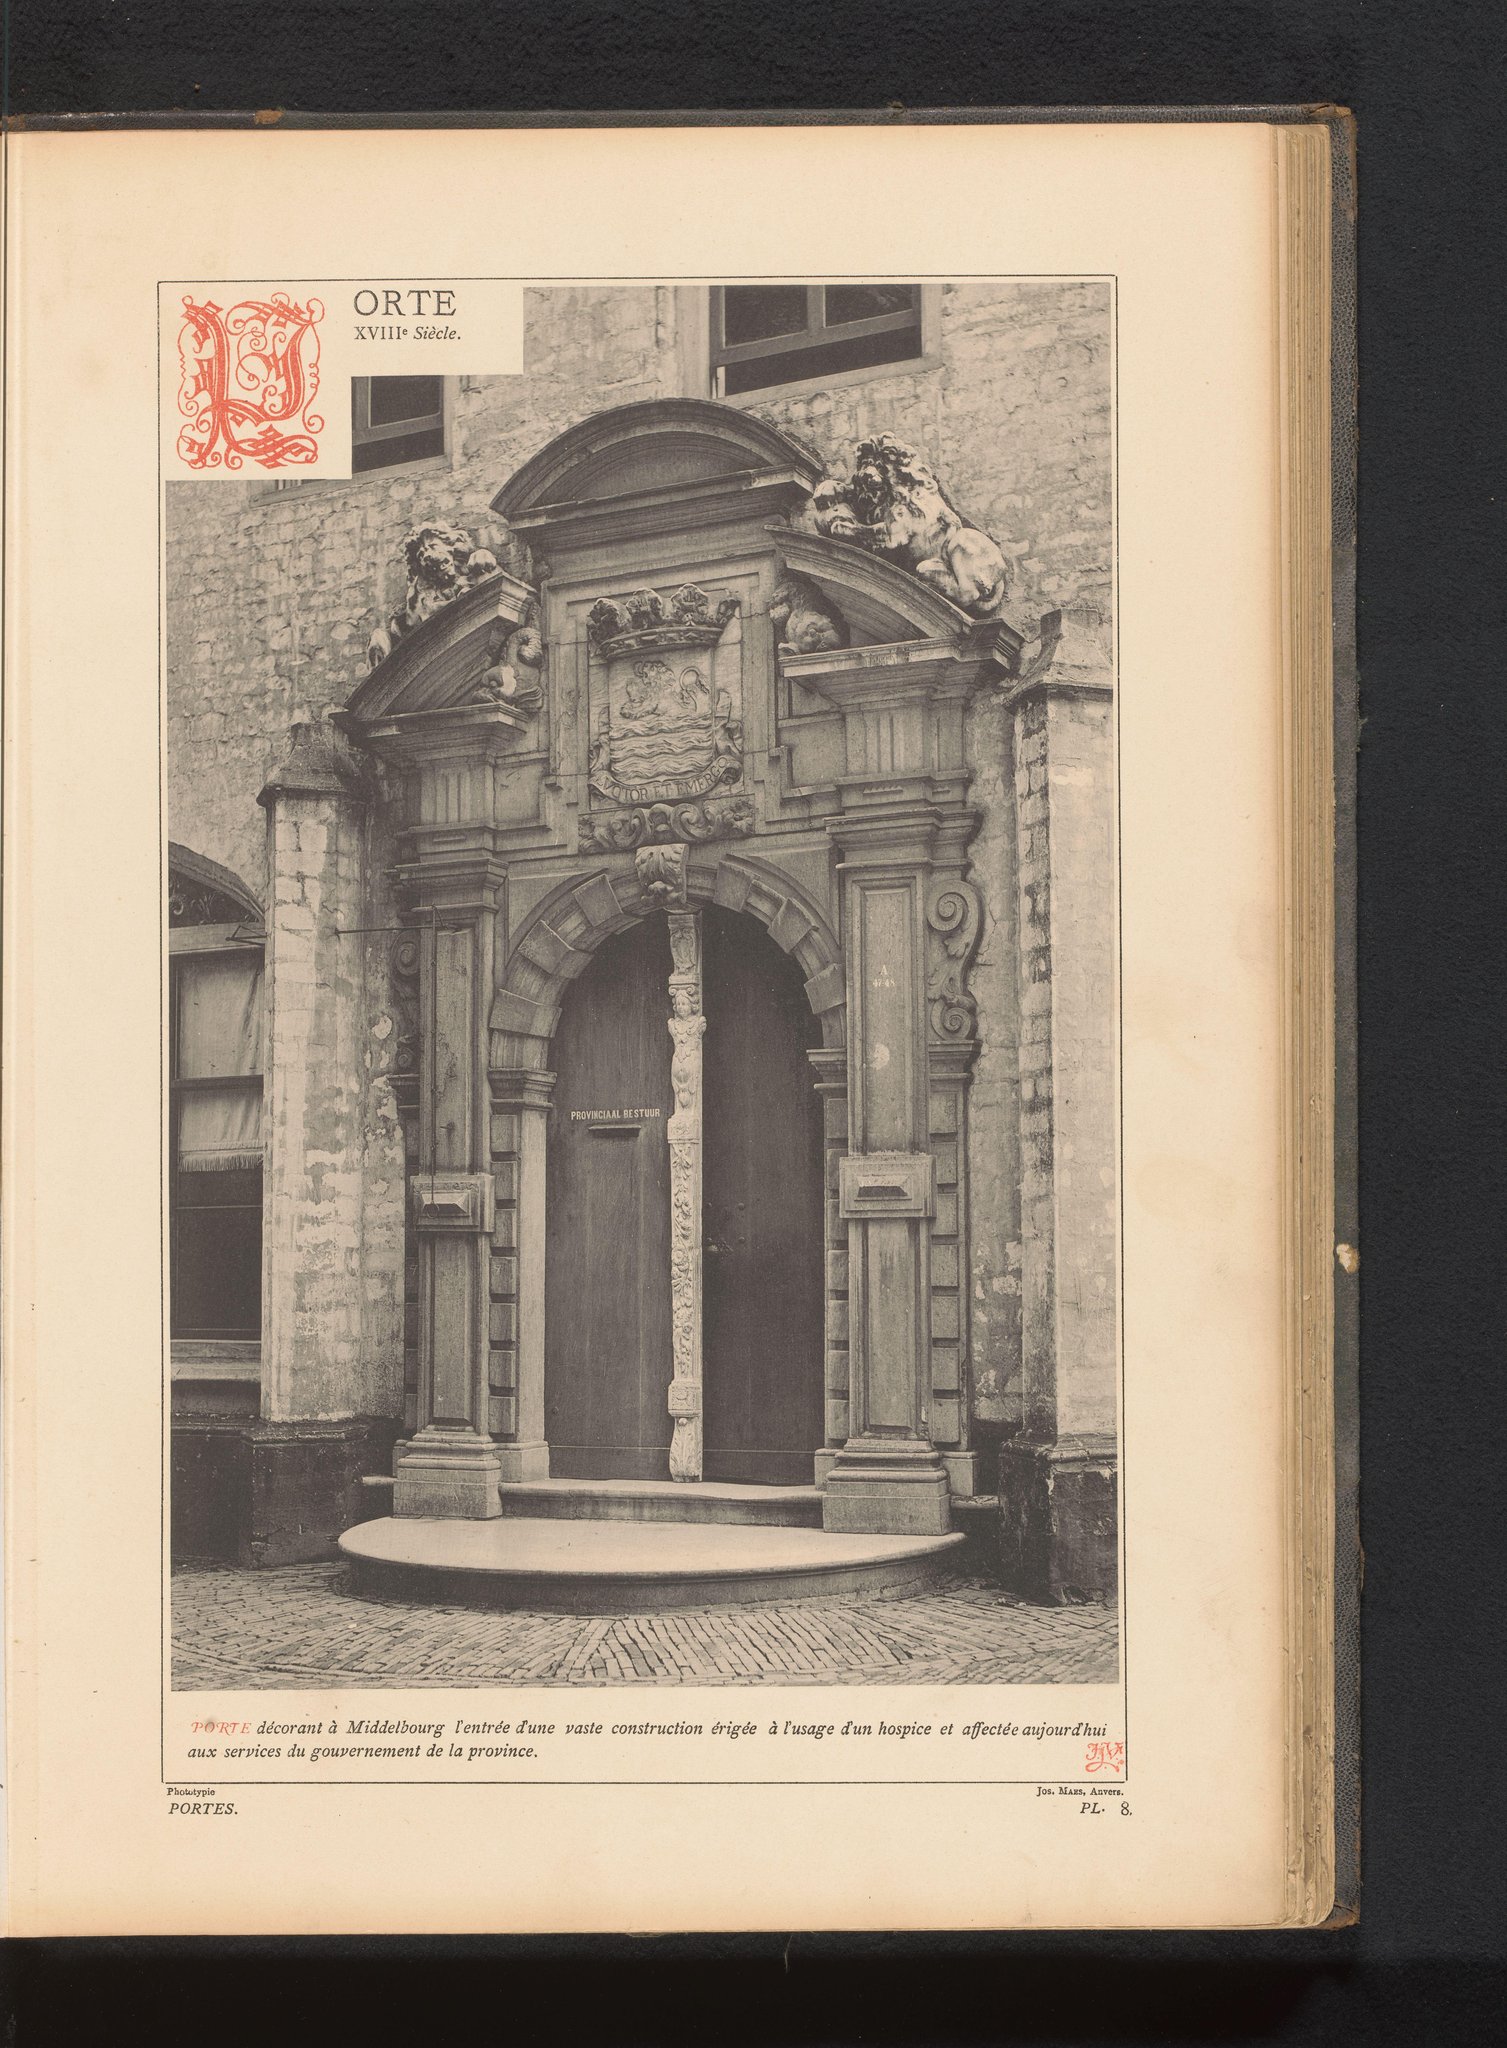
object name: photomechanical print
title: Porte XVIIIe, Siècle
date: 1881-1889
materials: paper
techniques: photograph, photolithography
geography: middelburg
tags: door, civic architecture; edifices; dwellings, middelburg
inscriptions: monogram: ‘JJvY’, inscription: ‘PORTE décorant à (...)’, inscription: ‘PORTES. PL. 8.’